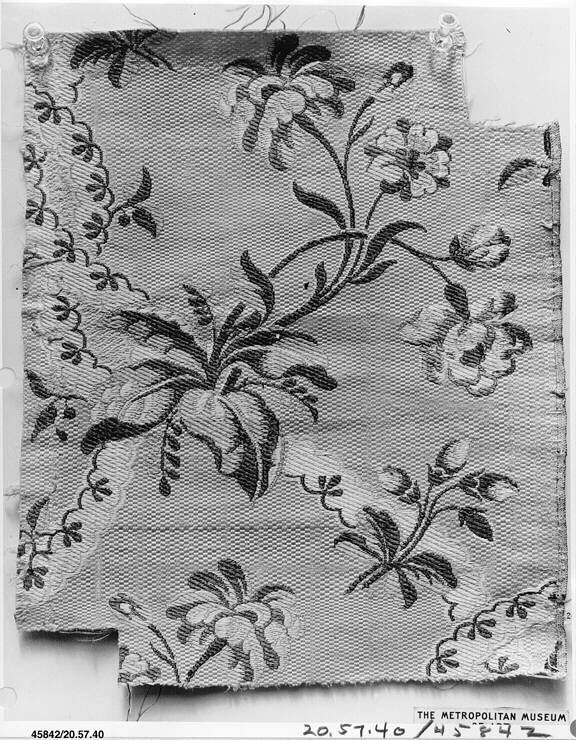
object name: piece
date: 1760-1770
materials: silk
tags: flowers,leaves